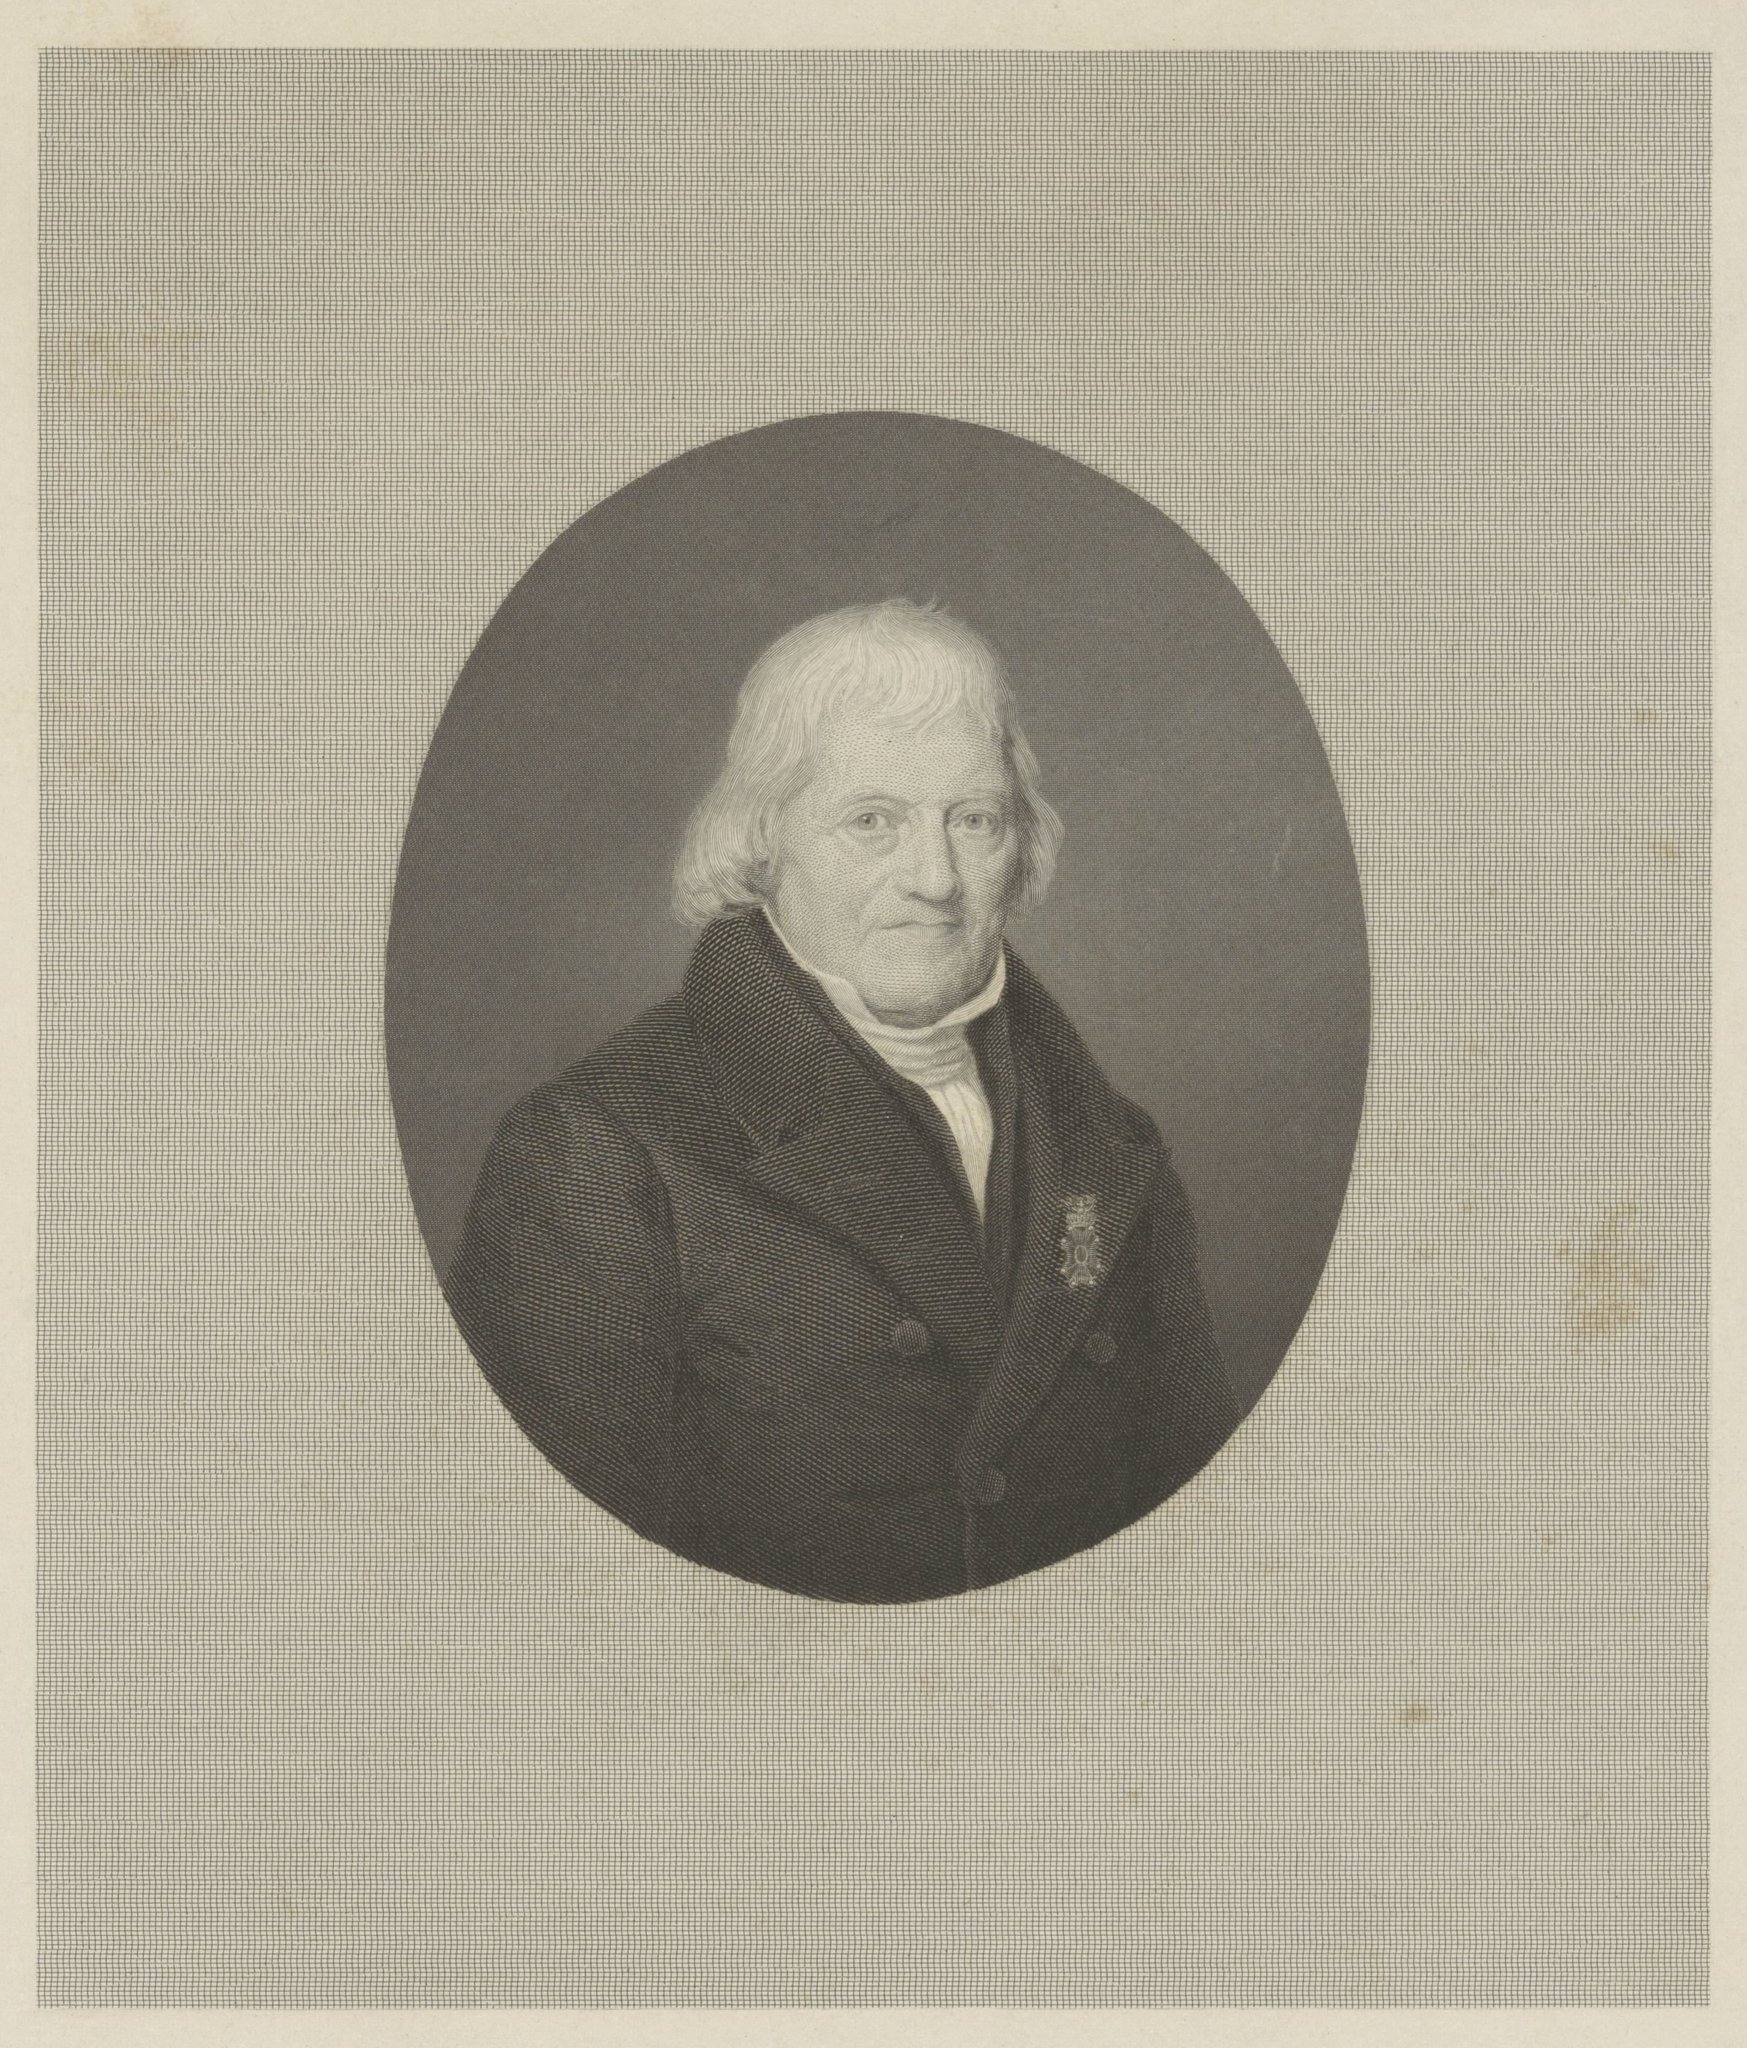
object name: print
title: Portret van Johannes Leonardus Wolterbeek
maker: johannes philippus lange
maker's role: print maker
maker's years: 1810-1849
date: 1848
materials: paper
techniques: engraving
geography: netherlands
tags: functionaries and dignitaries ~ protestant churches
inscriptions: company name: ‘Frans Buffa & Zonen / Amsterdam / Uitgevers’, inscription: ‘onafgewerkte proef 4’, collector's mark: Lugt 2228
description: Portret van de predikant Johannes Leonardus Wolterbeek op 85-jarige leeftijd, buste in ovaal naar rechts.